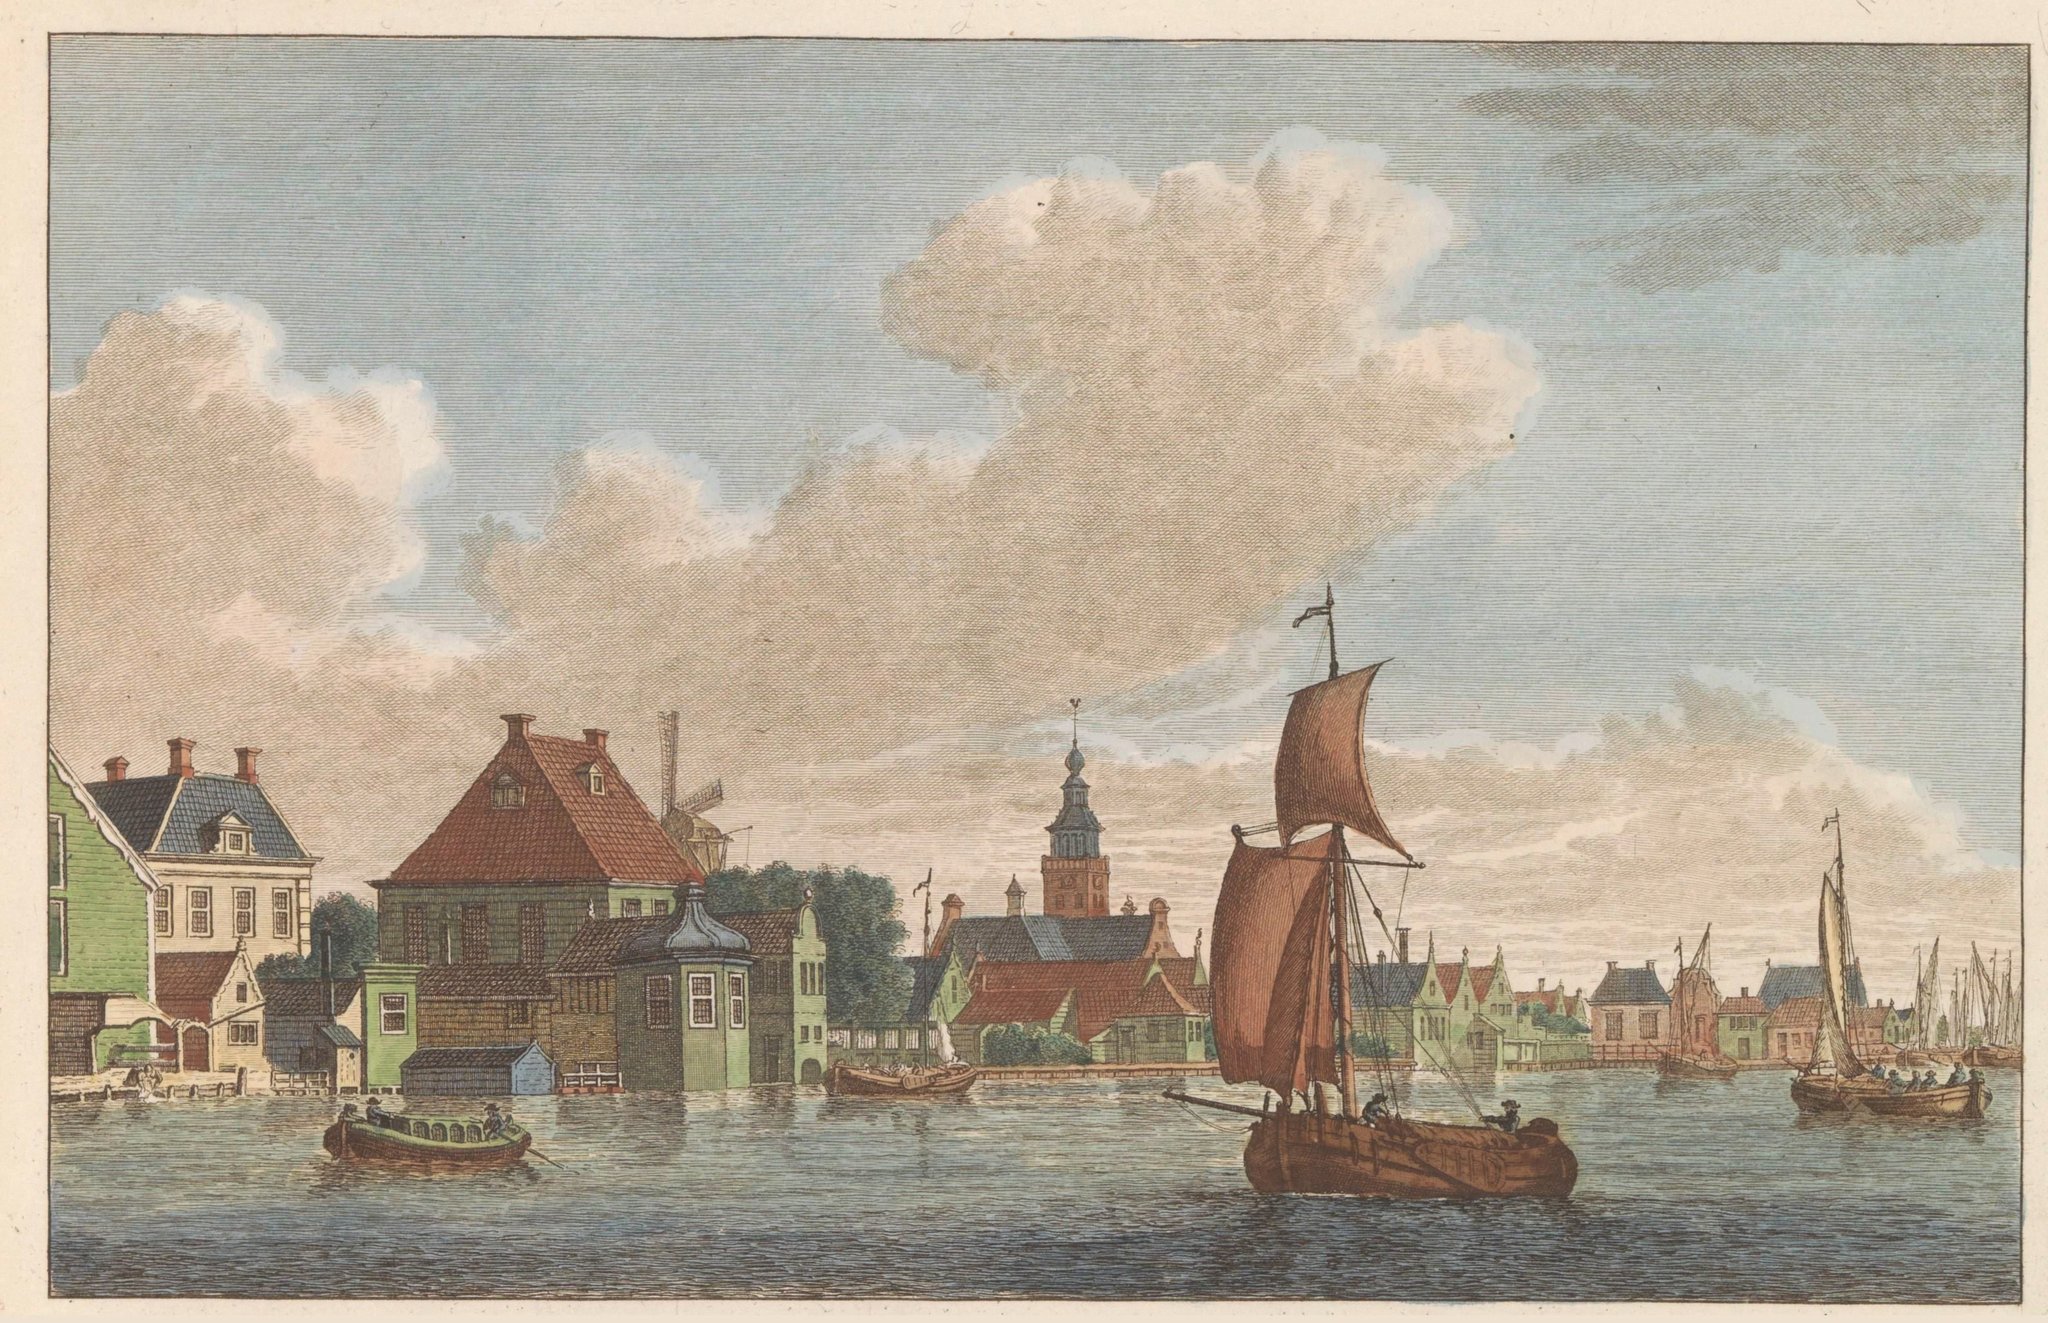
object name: print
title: Westzaan, ca. 1790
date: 1786-1792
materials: paper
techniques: engraving, etching, hand coloring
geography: amsterdam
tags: westzaandam, zaan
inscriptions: inscription: ‘chez E: Maaskamp à Amsterdam’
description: Huidige staat van prent uitgegeven als onderdeel van een plaatwerk uit ca. 1824-1825 met 74 (ongenummerde) platen van de belangrijkste topografische gezichten en verschillende zeden en gewoonten in het Verenigd Koninkrijk der Nederlanden, getiteld 'Tableau des principales vues des palais et édifices : représentations et des coutumes et usages, dans les provinces septentrionales du Royaume des Pays-Bas'. Eerdere staat gebruikt in: Vaderlandsche gezichten, of afbeeldingen van den tegenwoordigen staat der Vereenigde Nederlanden (…). Amsterdam: Hendrik Gartman, Willem Vermandel en Jan Willem Smit, 1786-1792. Uitgegeven in afleveringen met ieder een eigen bifolium en inhoudsopgave. Alle prenten in deze publicatie zijn gegraveerd door Carel Frederik Bendorp (I) en, in de meeste gevallen, gebaseerd op tekeningen van Jan Bulthuis.